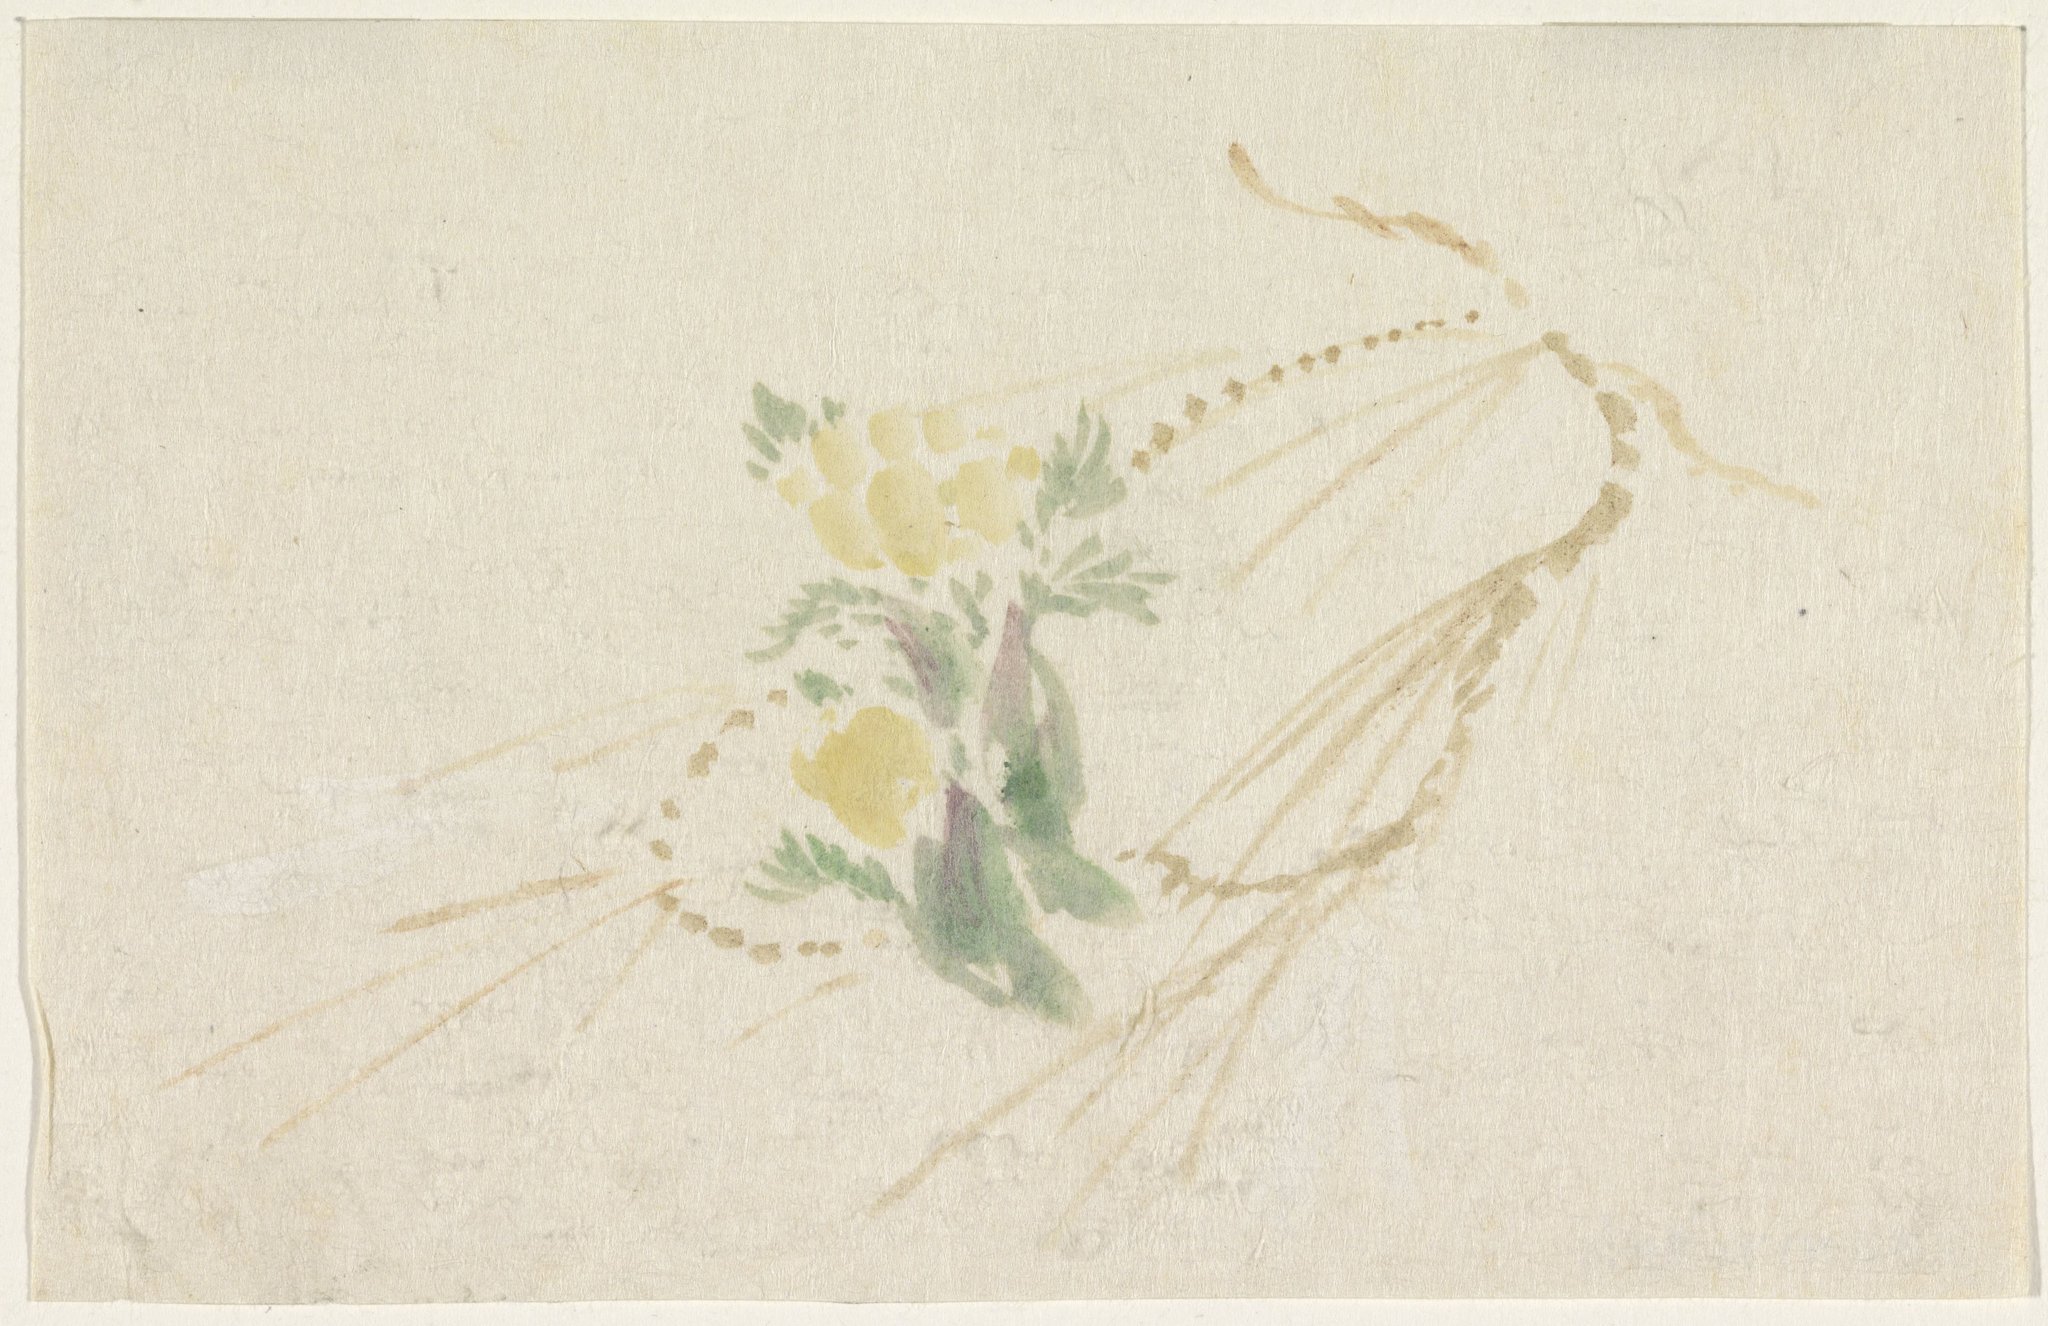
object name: drawing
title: Tak met gele bloemen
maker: utagawa kuniyoshi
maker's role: draughtsman, print maker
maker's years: 1798-1861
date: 1808-1861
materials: paper, watercolor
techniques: brush